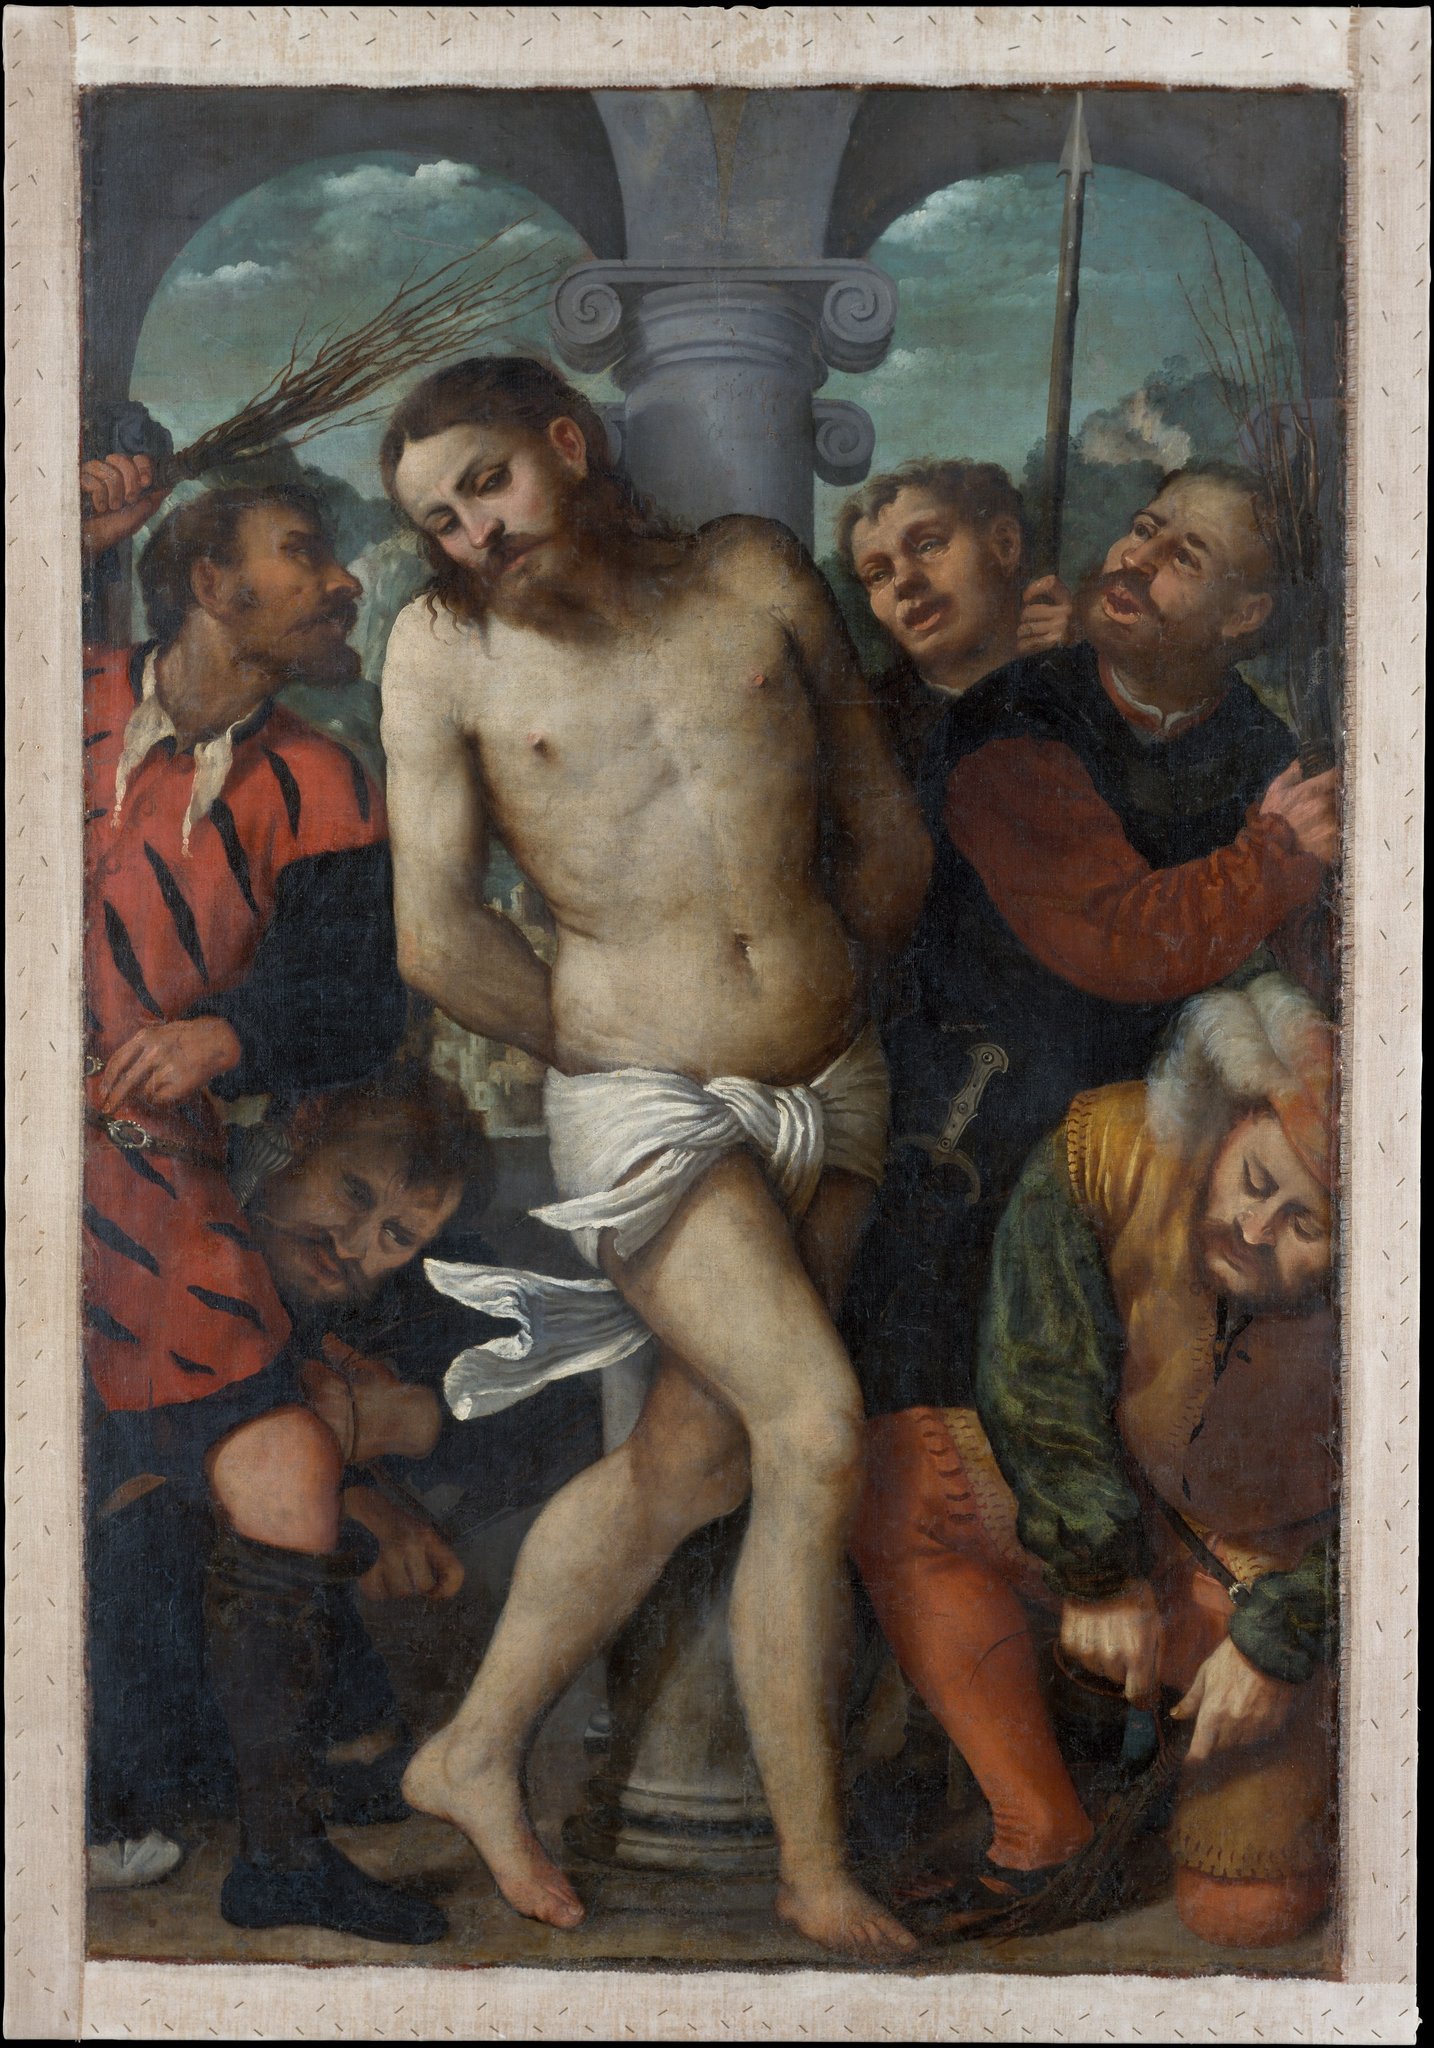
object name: painting, processional banner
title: The Flagellation; (reverse) The Madonna of Mercy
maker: girolamo romanino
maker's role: artist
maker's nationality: italian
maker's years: 1484-1560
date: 1540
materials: canvas, oil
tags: men,christ,virgin mary,saints